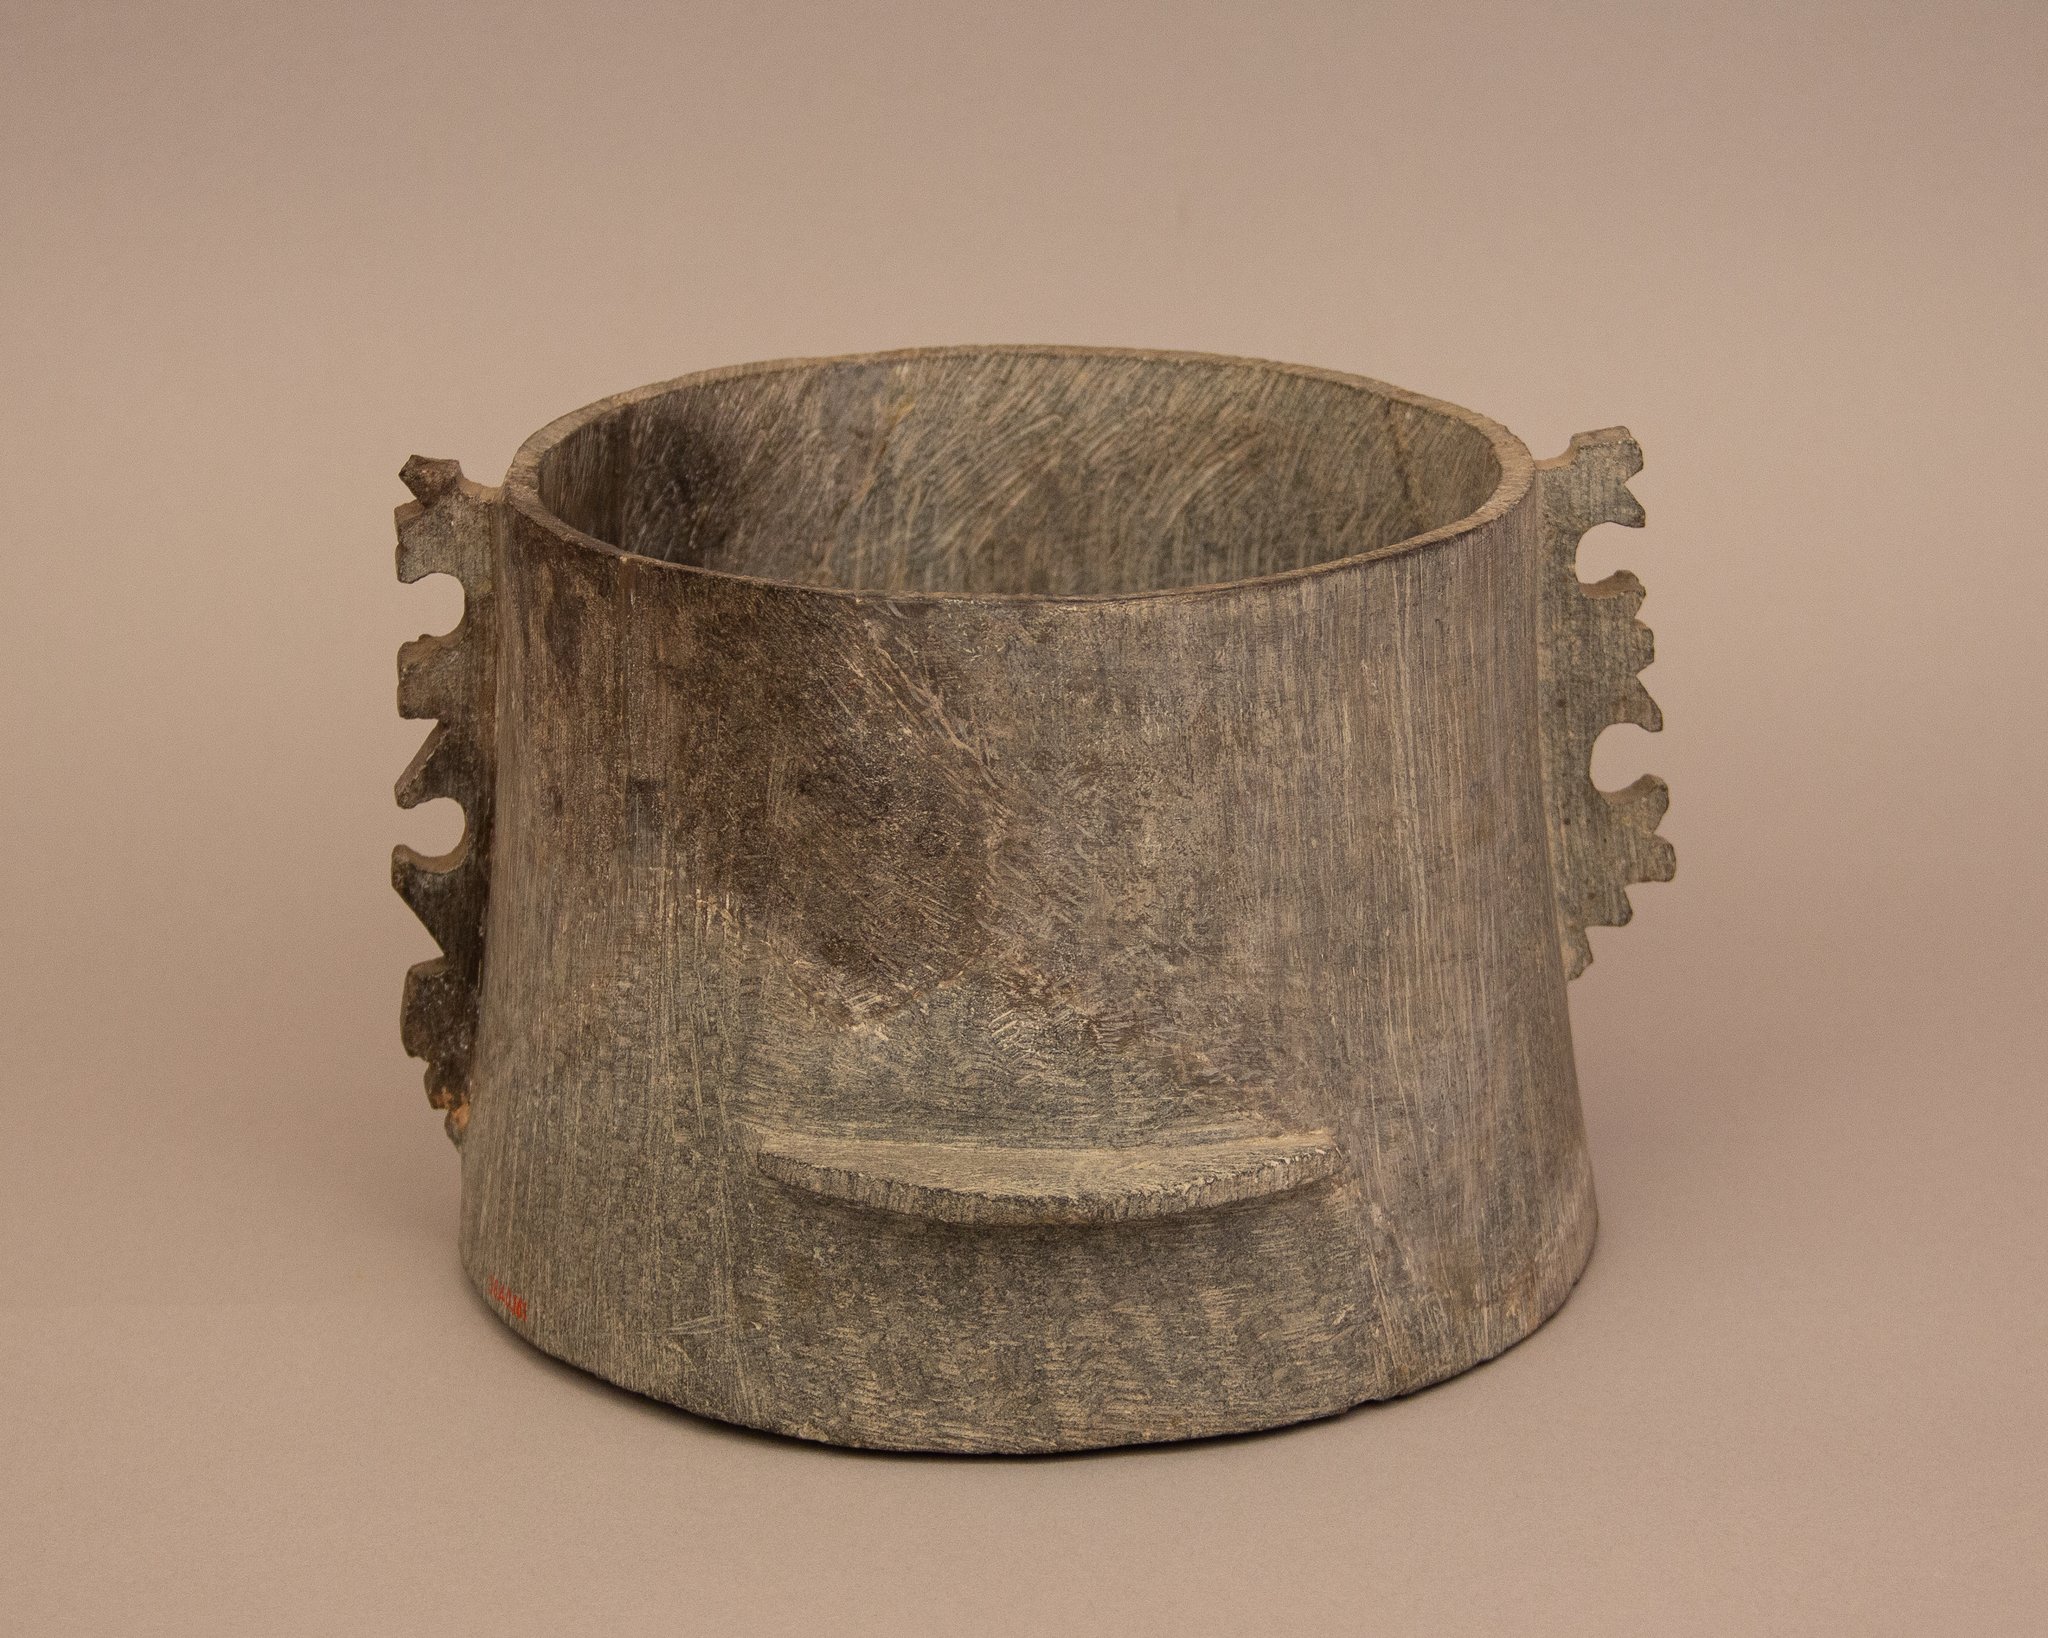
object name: cauldron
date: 801-900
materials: stone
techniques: carving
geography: iran